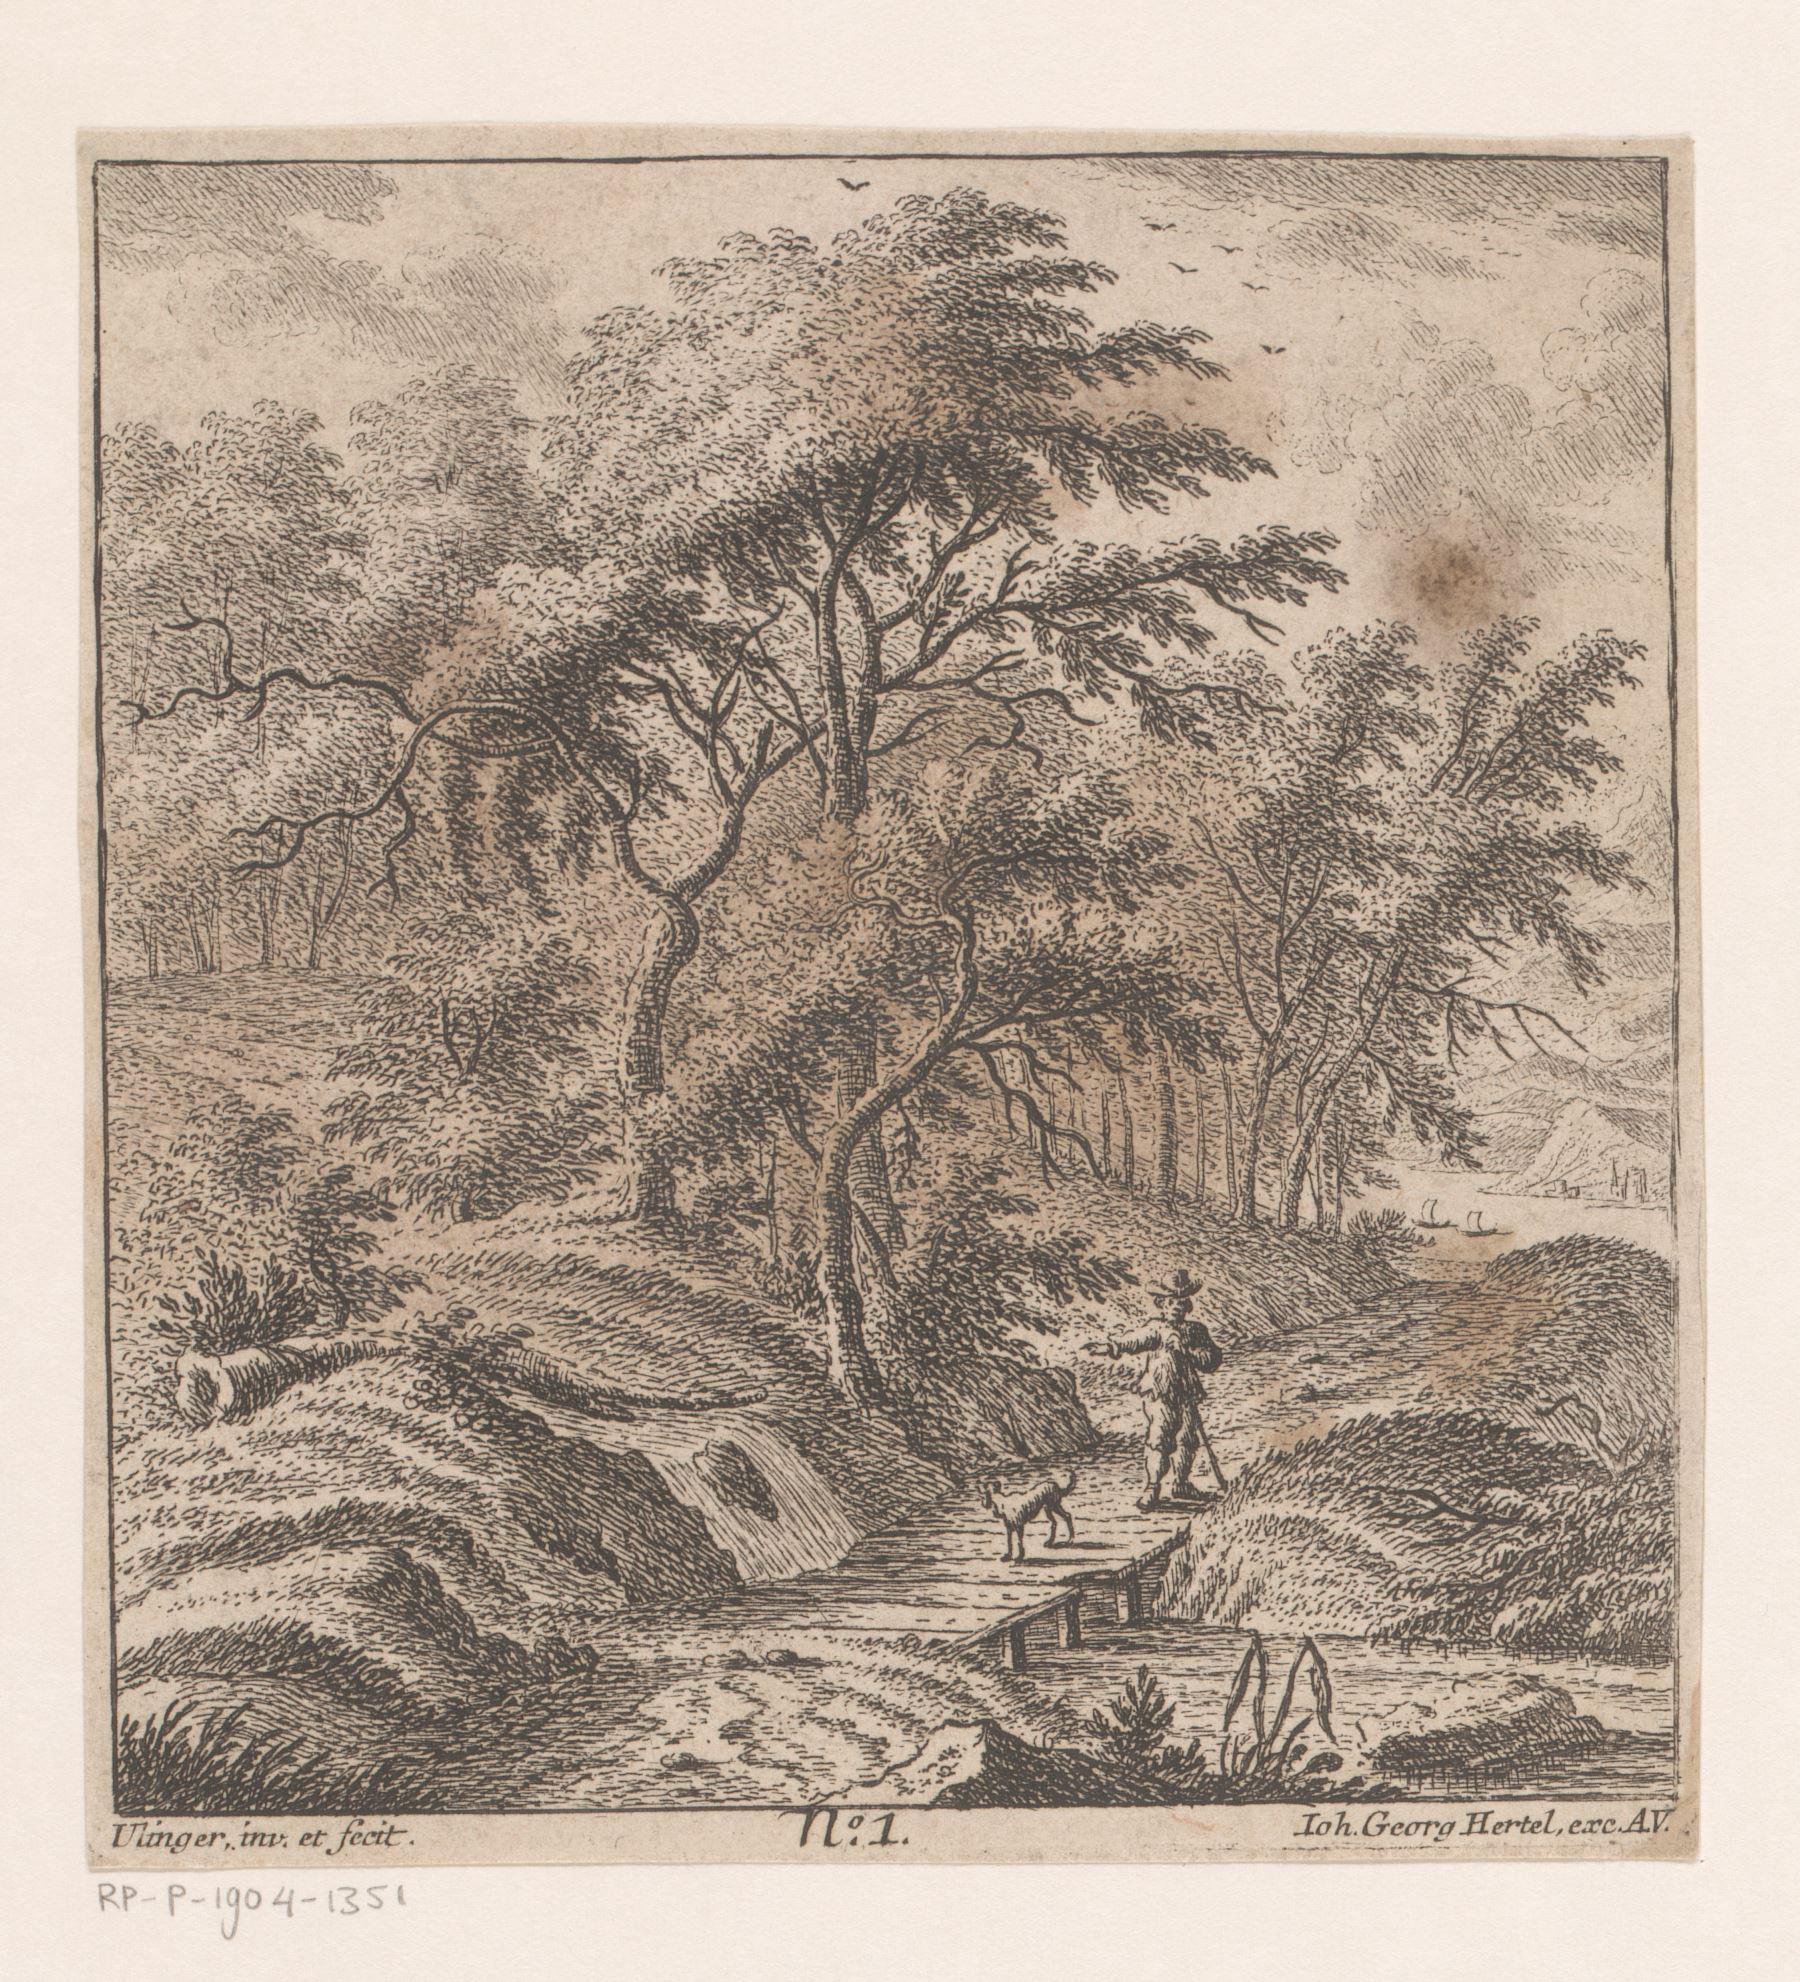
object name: print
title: Man met een hond wandelend langs een bosrand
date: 1713-1768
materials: paper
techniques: etching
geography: switzerland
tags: landscape with bridge, viaduct or aqueduct, forest, wood, 'en route', traveller under way, dog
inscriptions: collector's mark: Lugt 2228